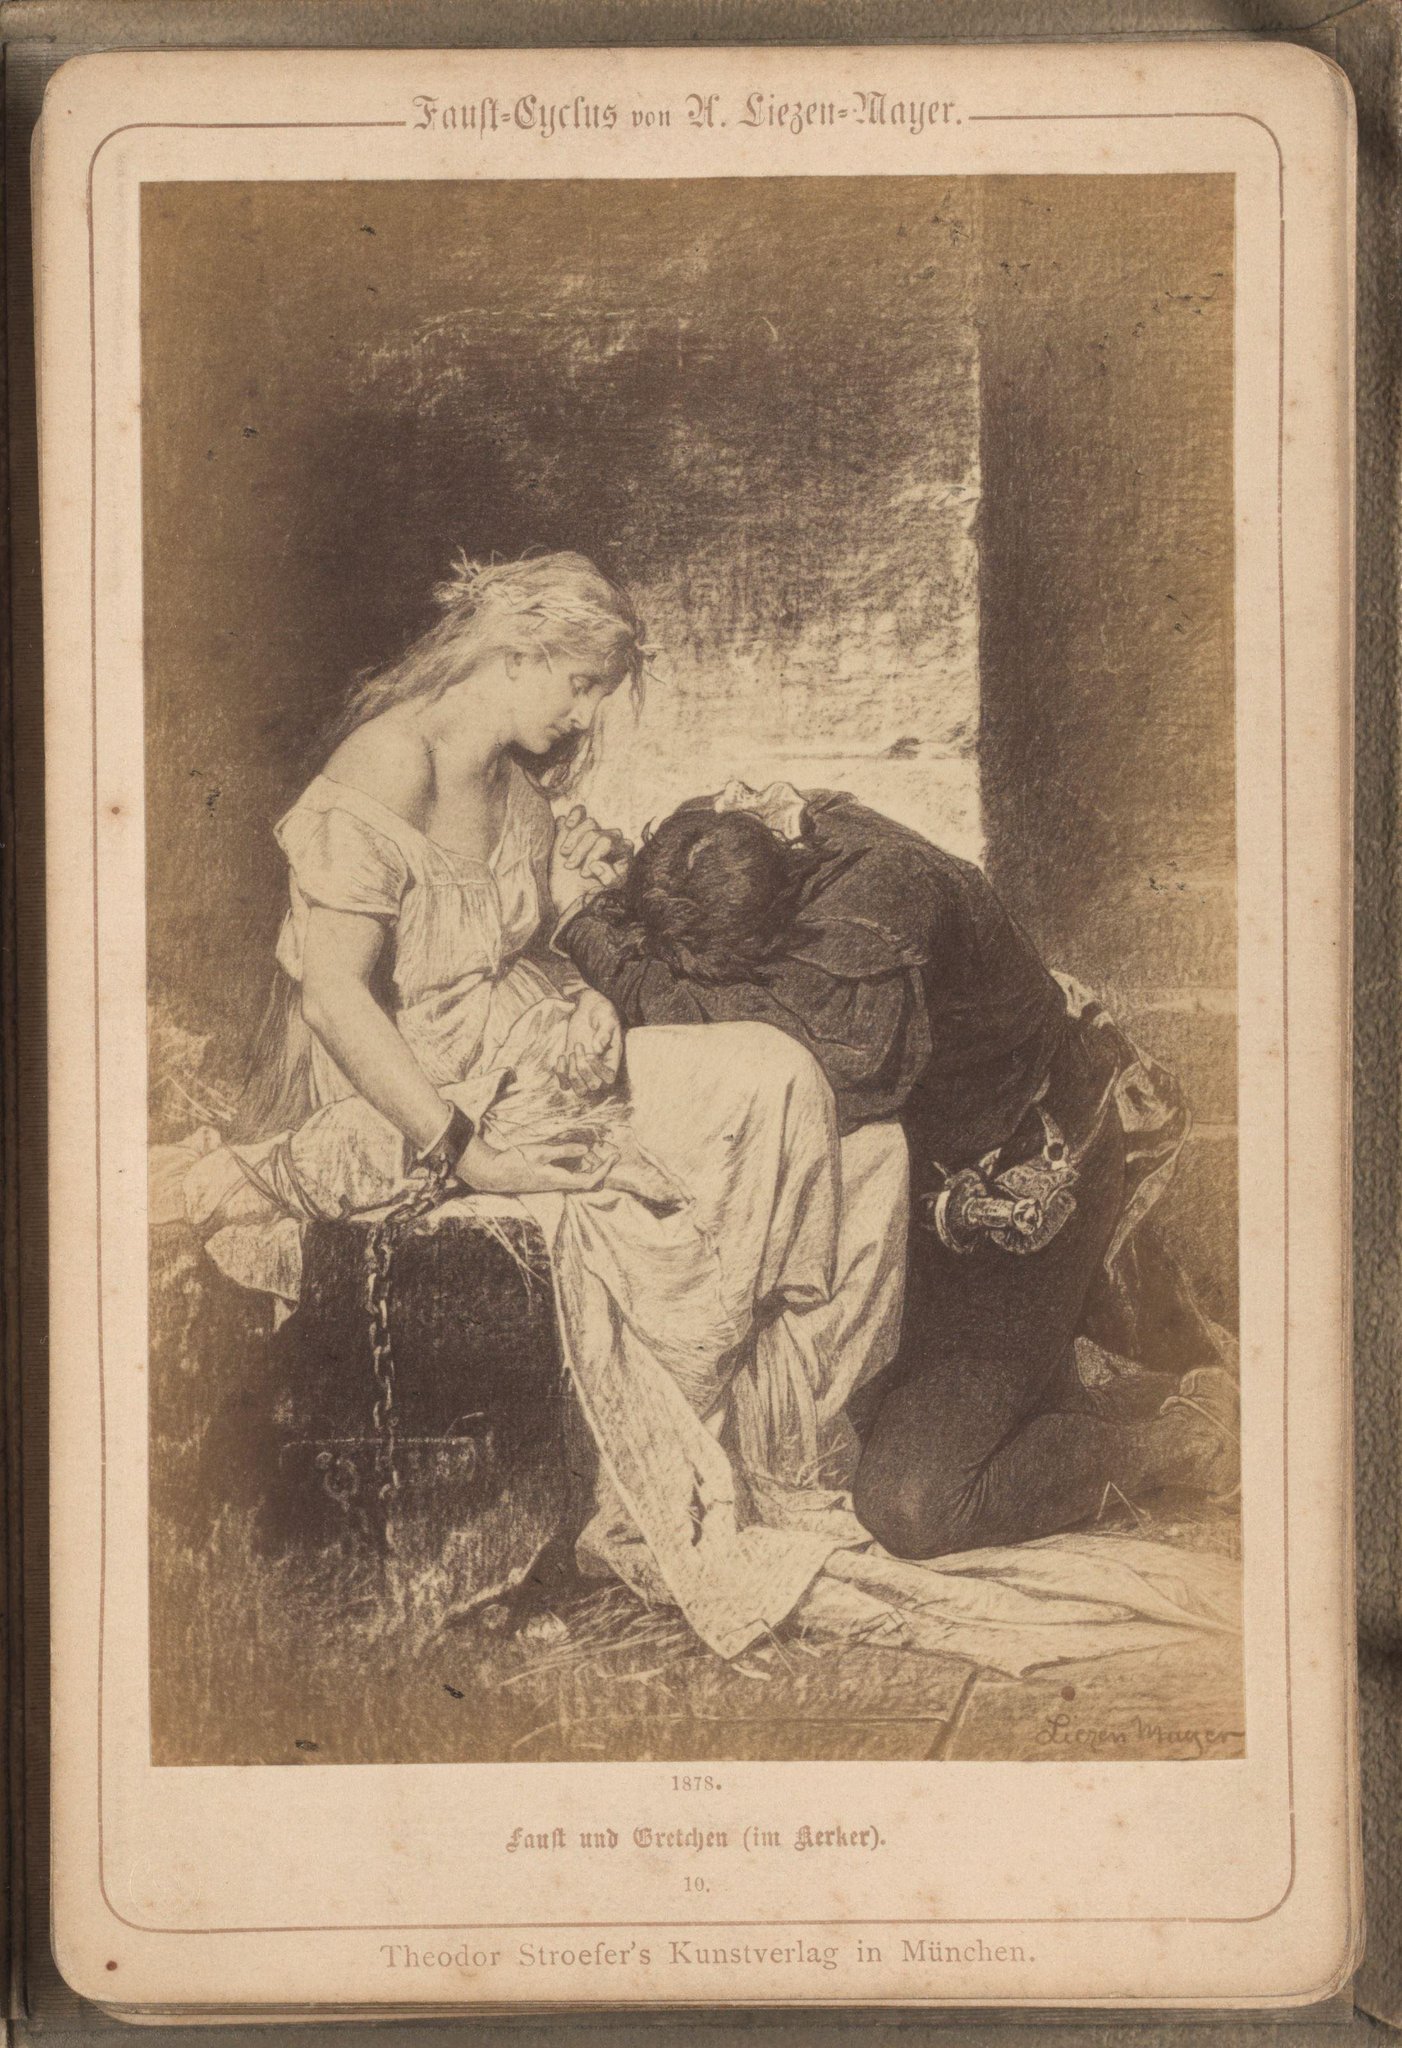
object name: photograph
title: Fotoreproductie van (vermoedelijk) een tekening getiteld 'Faust en Gretchen in de kerker'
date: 1878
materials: cardboard, paper, photographic support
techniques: albumen print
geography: munich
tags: prison, jail, gretchen, faust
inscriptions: number: ‘10’, check stamp: ‘TS’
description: Onderdeel van Album met 30 fotoreproducties van tekeningen van het Faust-verhaal van J.W. von Goethe.